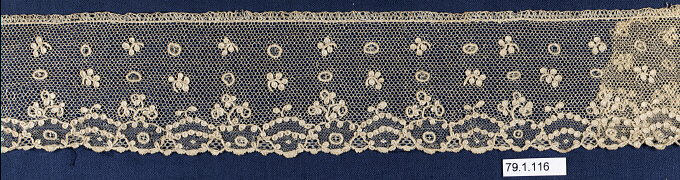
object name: strip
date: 1701-1800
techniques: lace